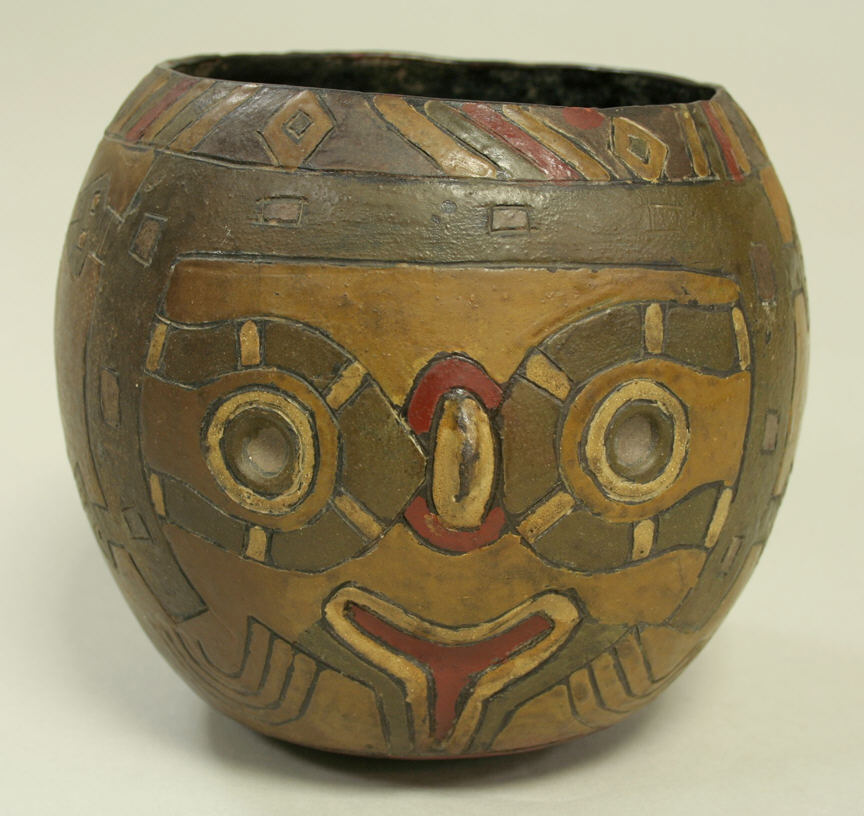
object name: bowl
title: Bowl, Face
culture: paracas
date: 500-301 BCE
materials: ceramic, pigment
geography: peru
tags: faces